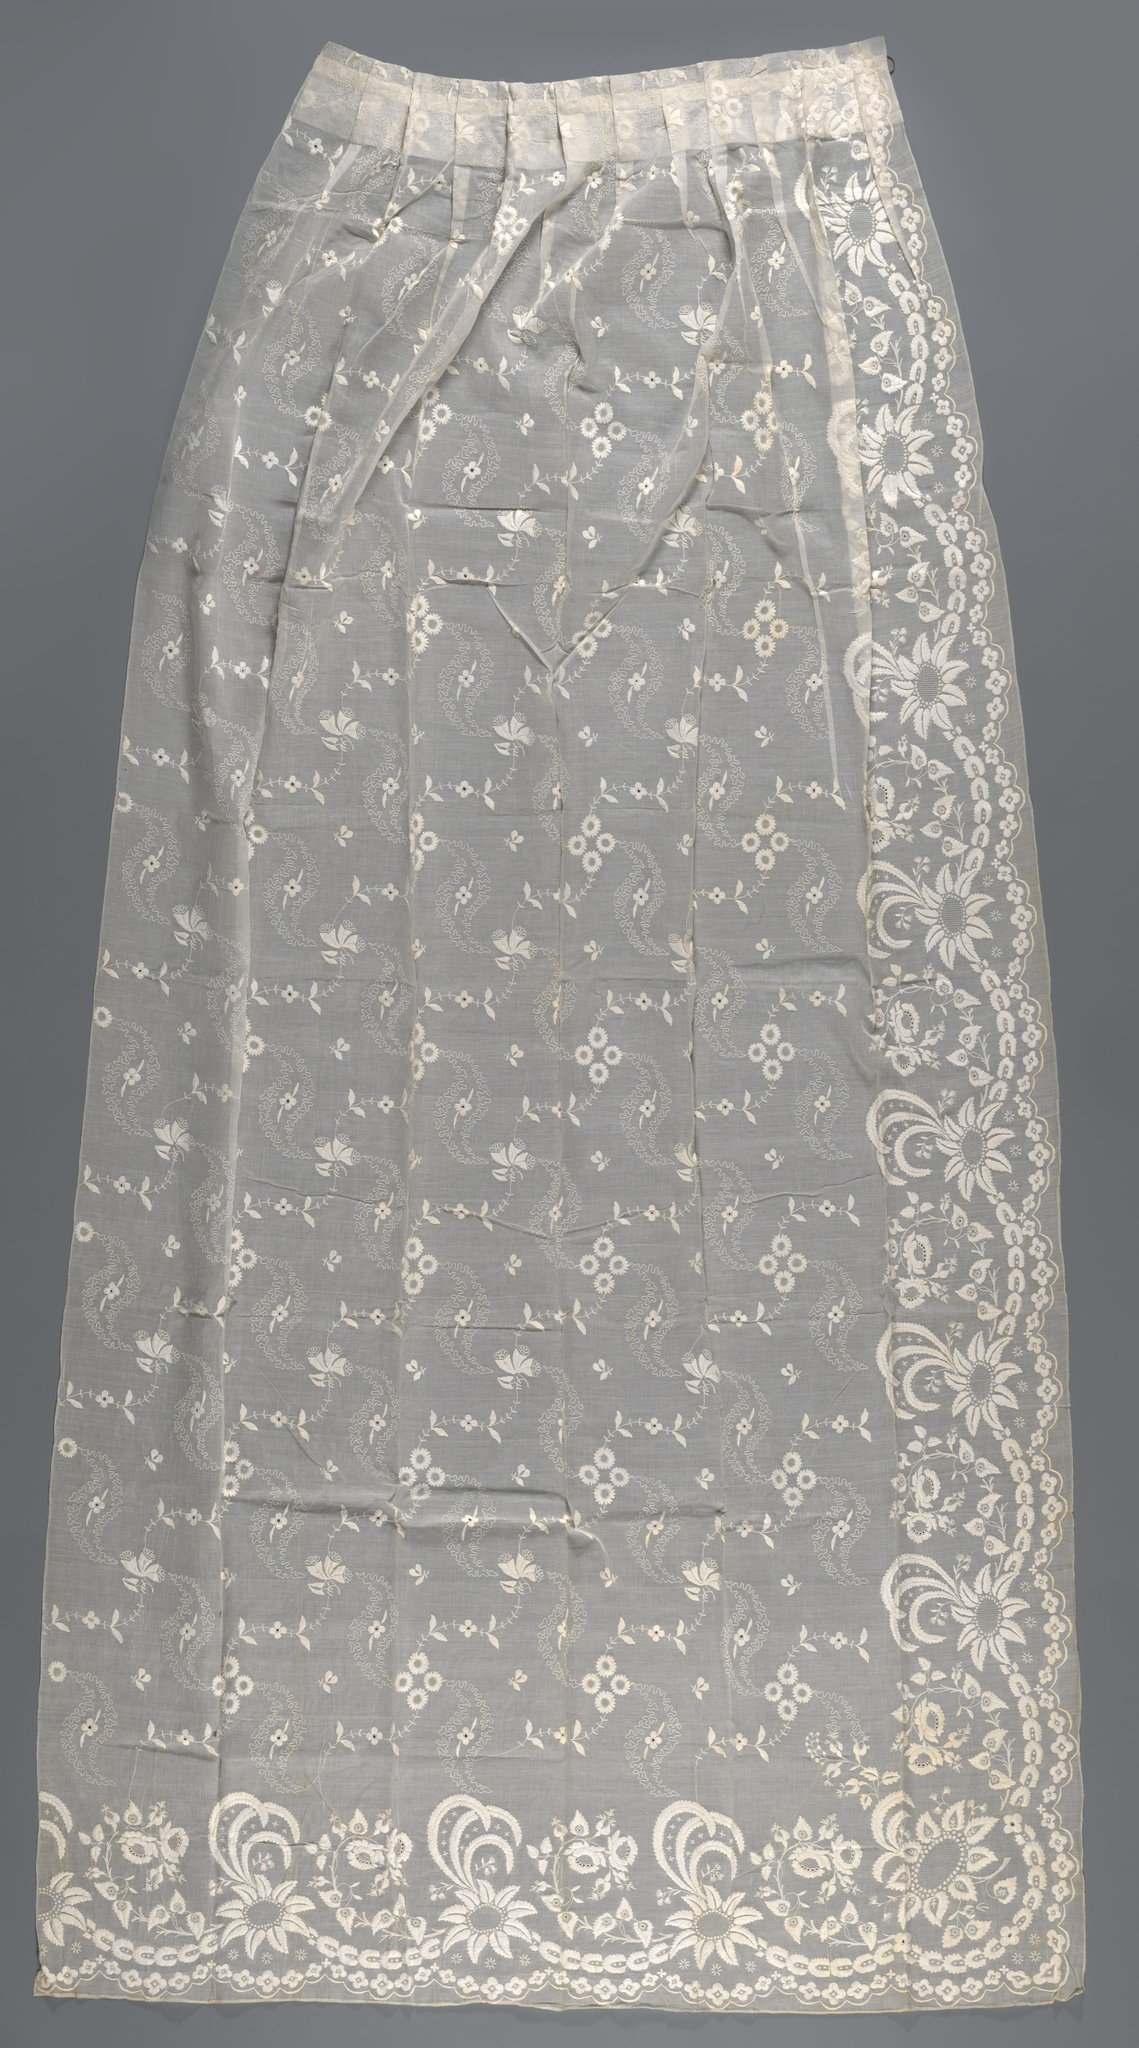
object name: curtain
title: Gordijn van glasbatist versierd met tule doorstopborduursel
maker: Anonymous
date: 1800-1874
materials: textile, copper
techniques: stopwork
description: Gordijn van glasbatist, versierd met tule doorstopborduursel (wit op wit) in de vorm van margrieten en andere bloemen. Aangenaaid band met koperen ringen. Onderaan met potlood gemerkt: 105 18/4 4 (?).